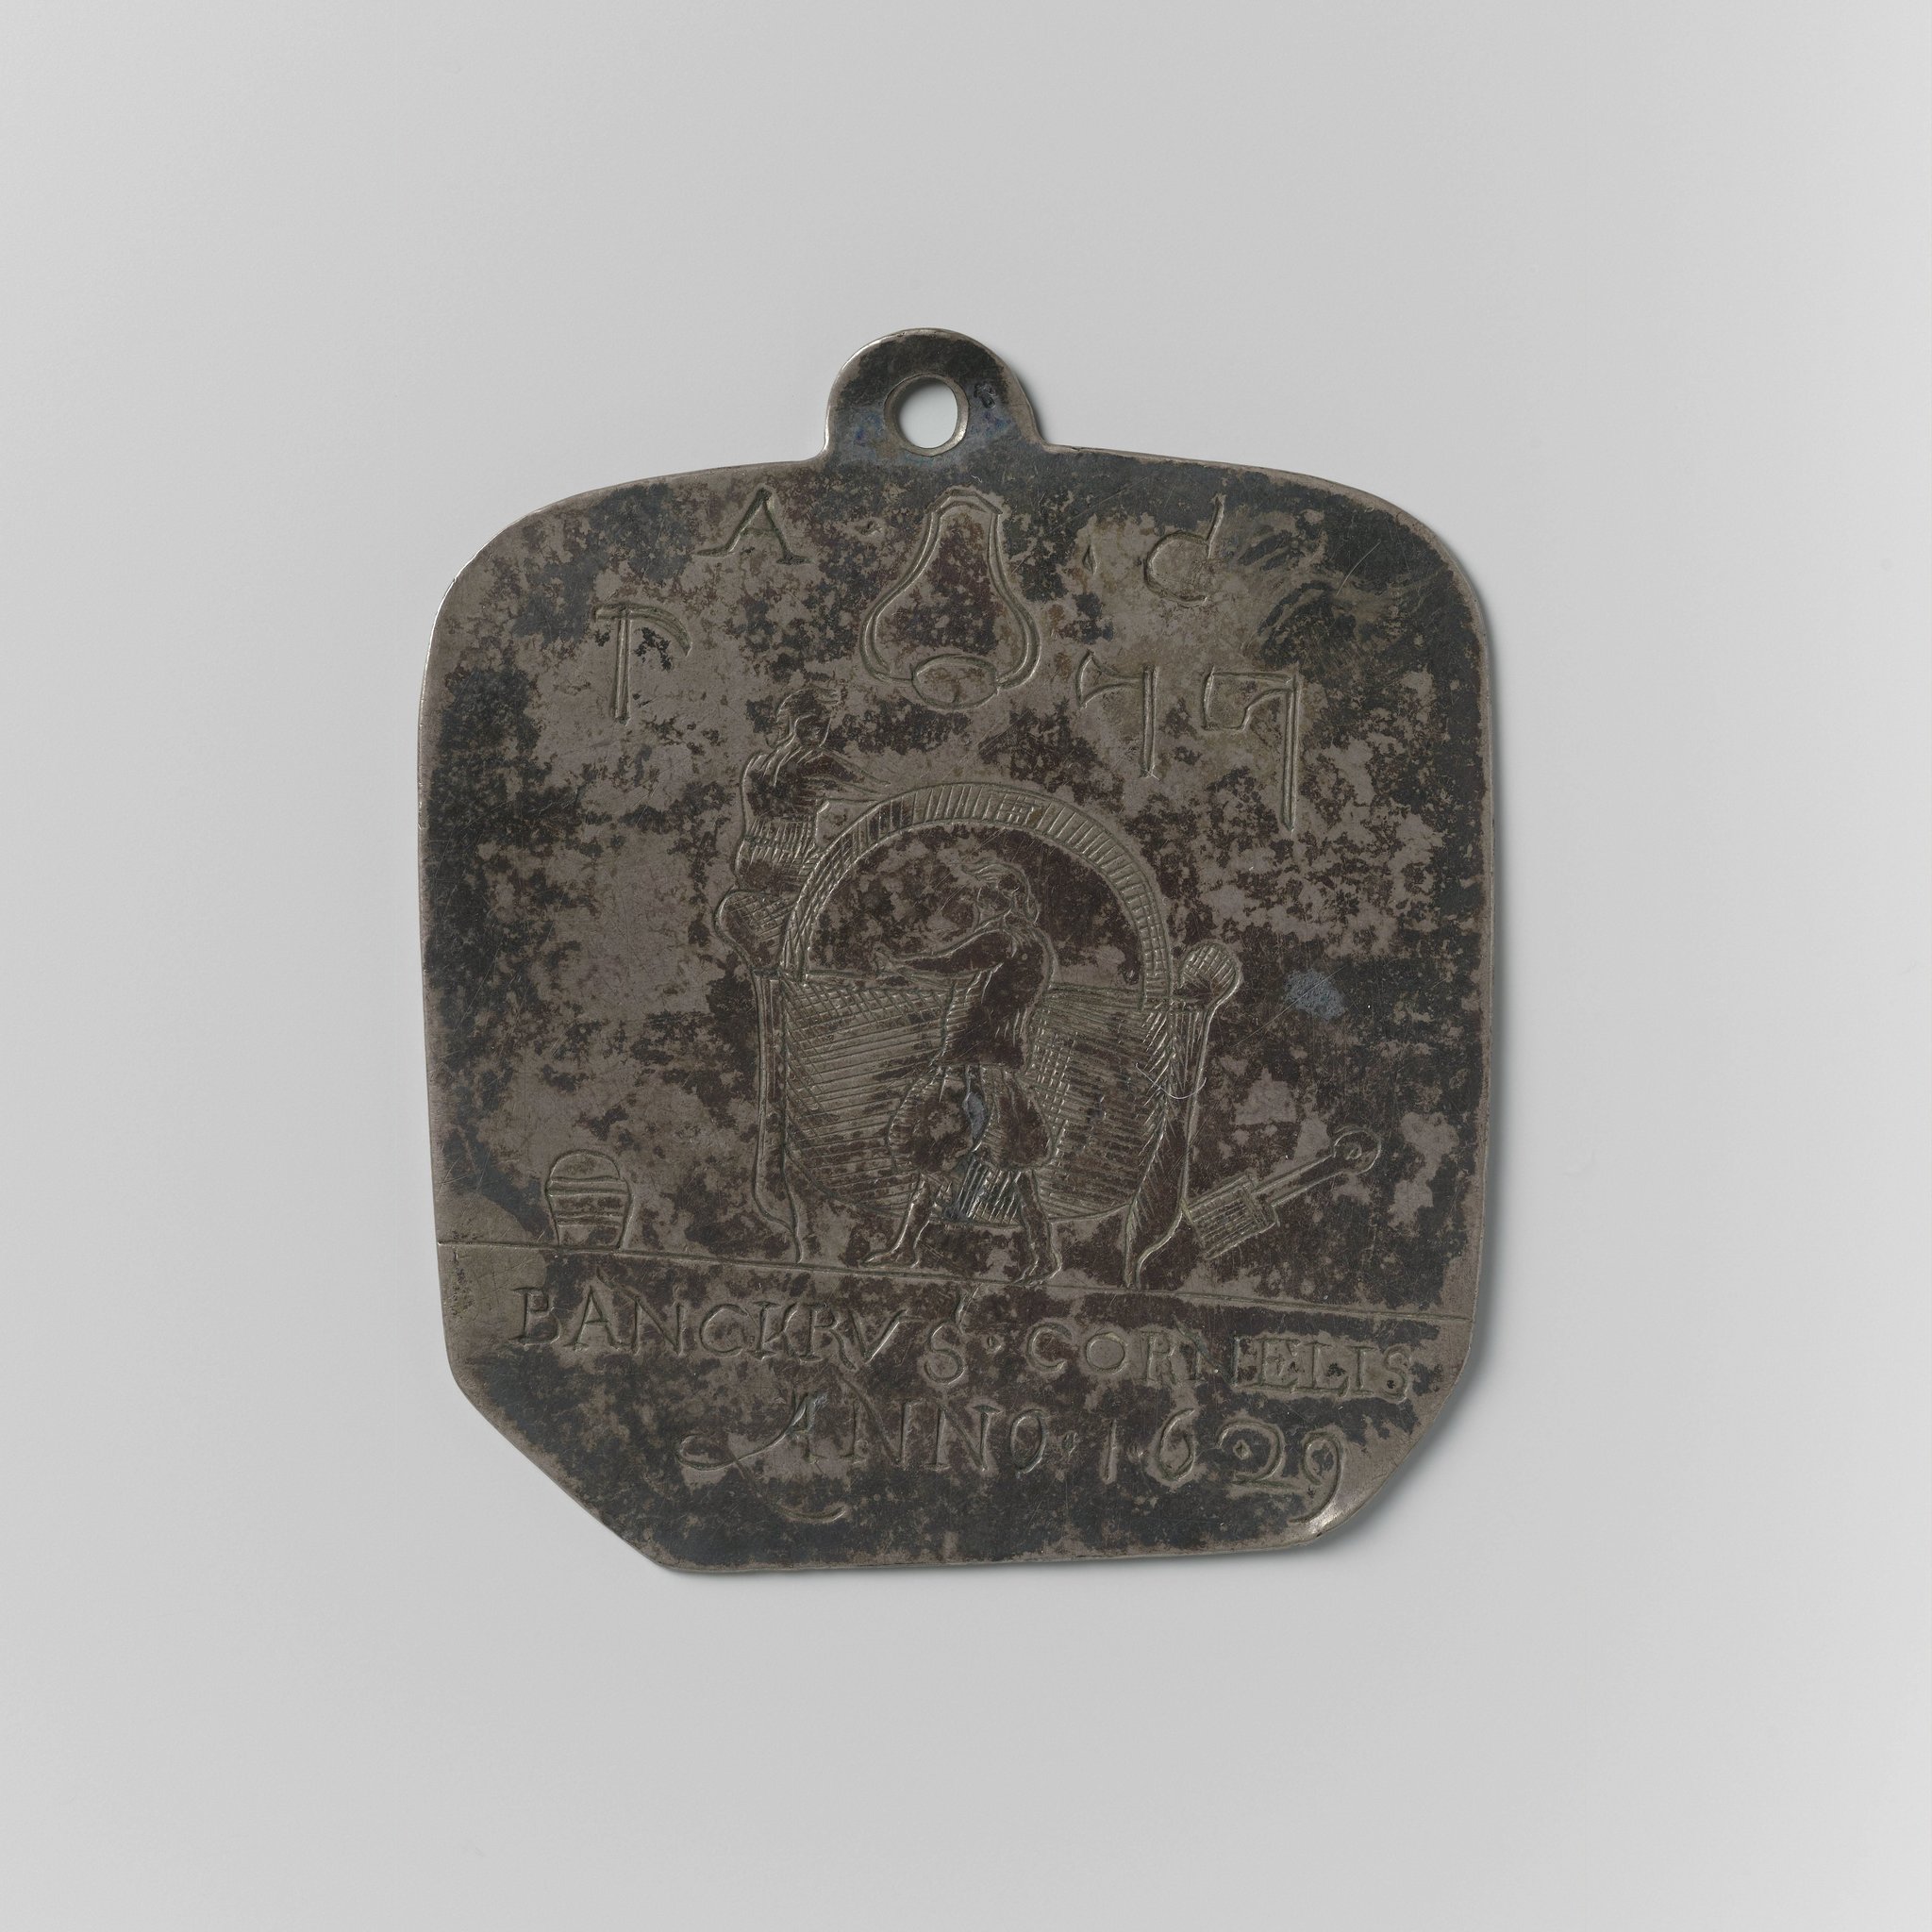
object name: medal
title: Scharenslijpersgilde van Amsterdam, gildepenning van Cornelis Banckrus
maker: Anonymous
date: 1629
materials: silver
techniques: engraving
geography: amsterdam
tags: amsterdam